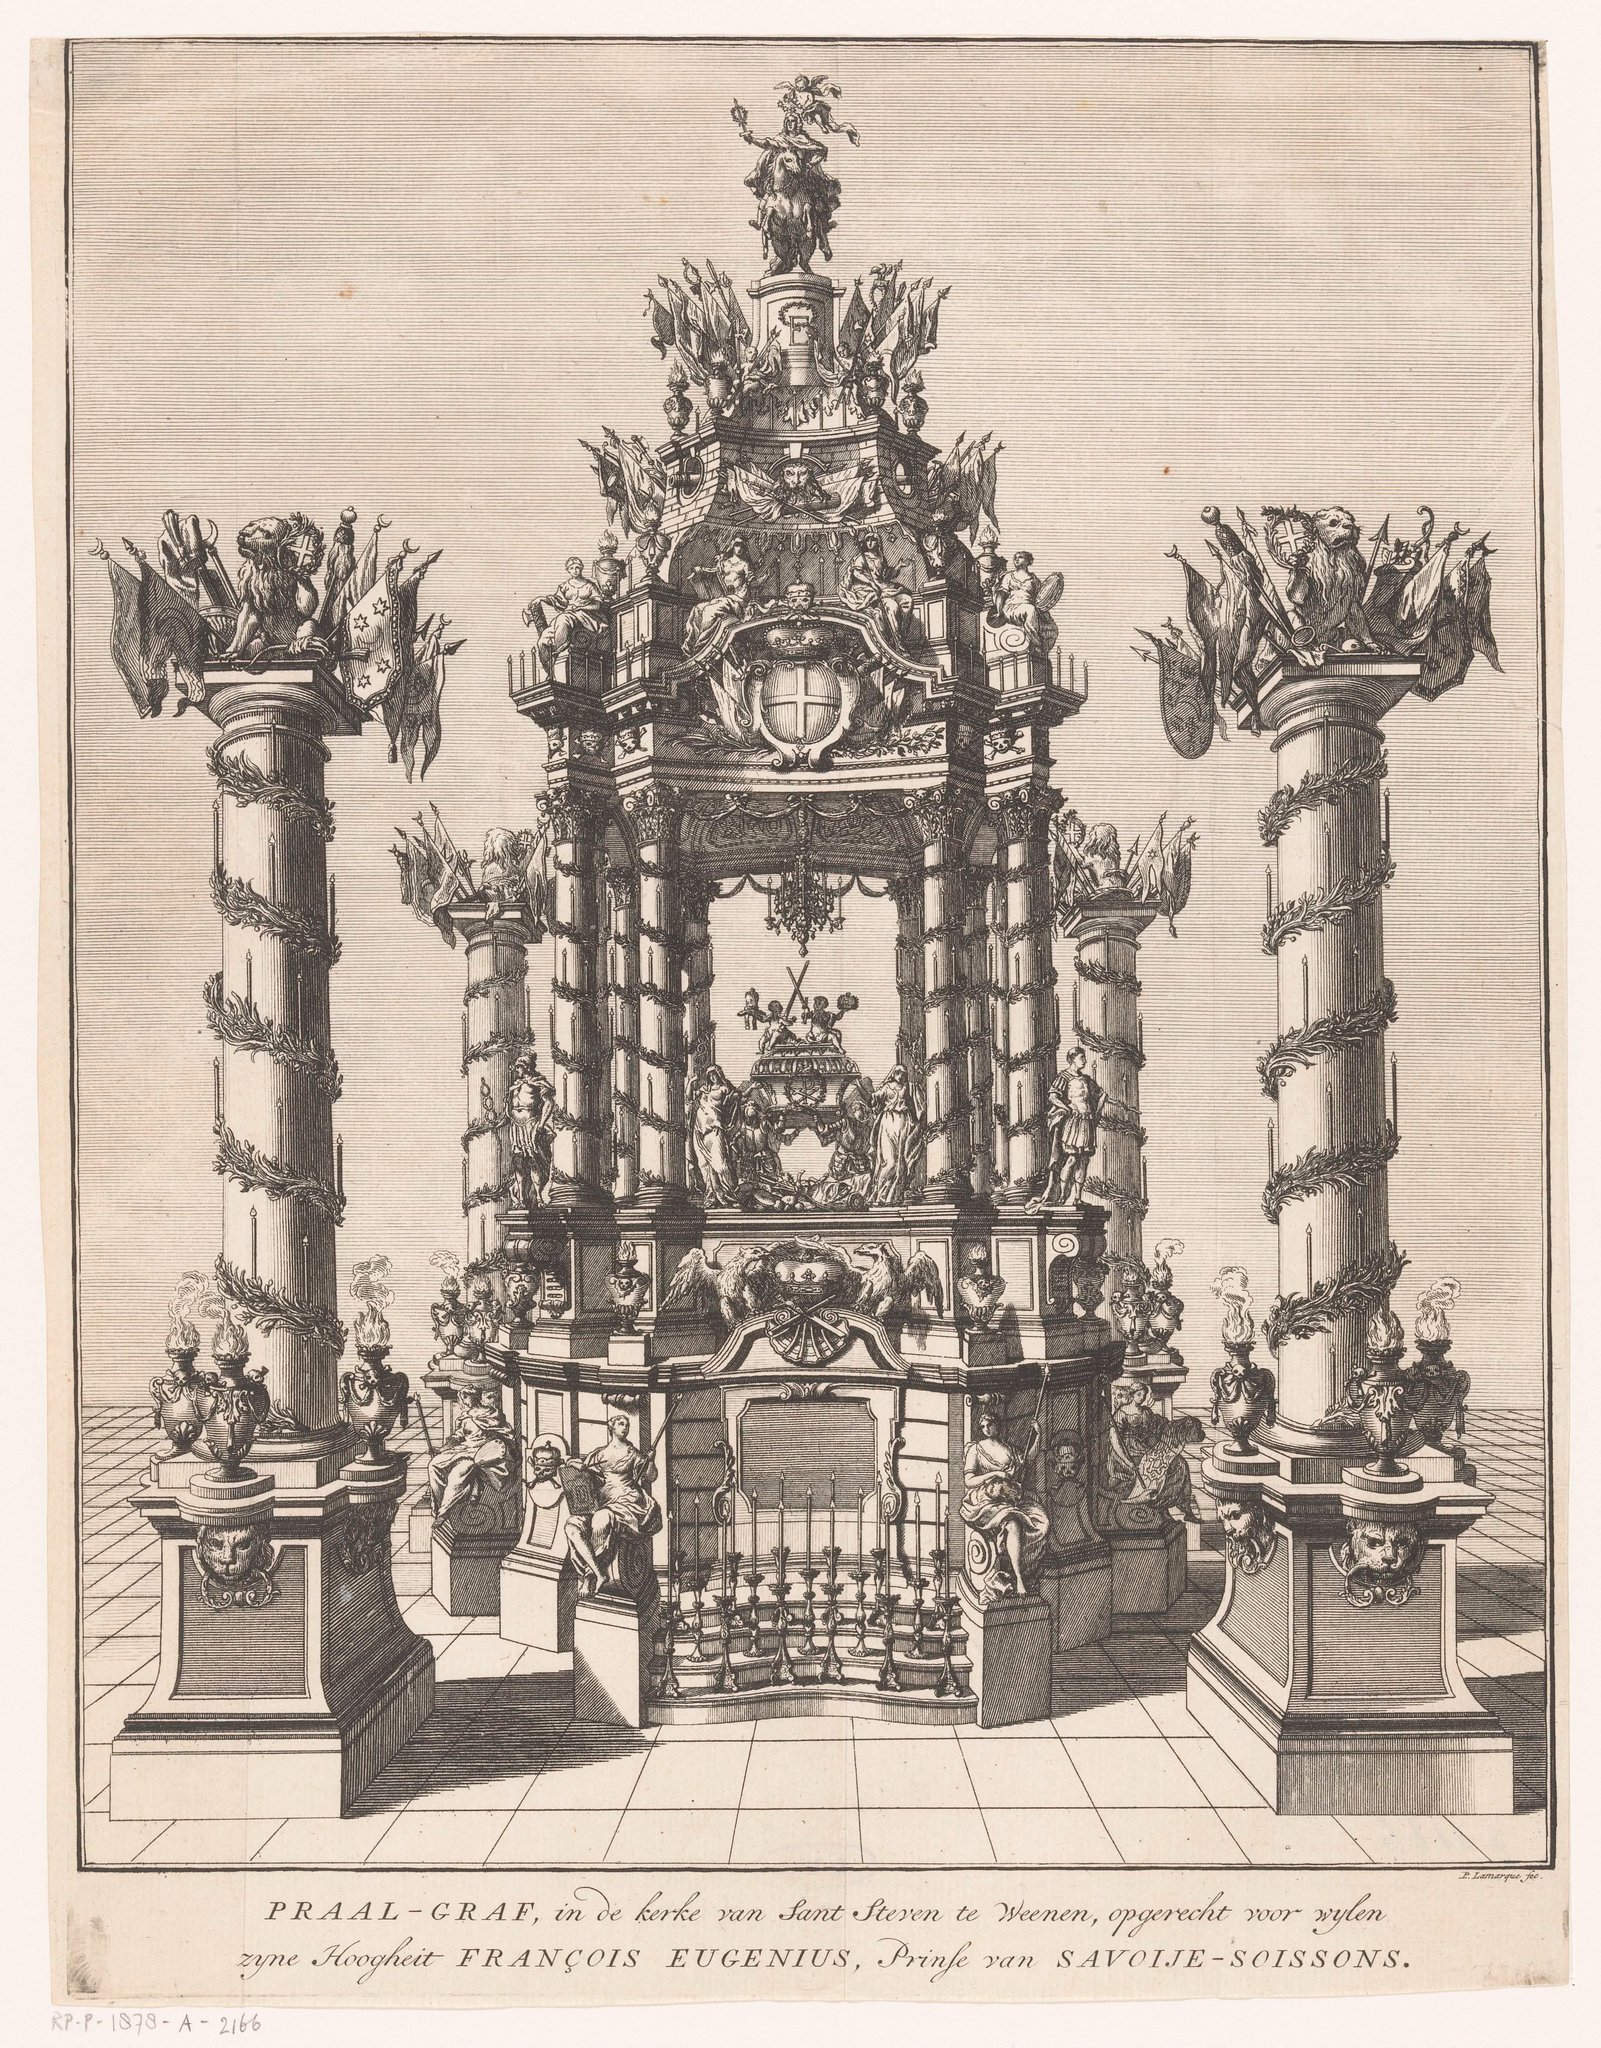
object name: ornament print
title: Praal-Graf, in de kerke van Sant Steven te Weenen, opgerecht voor wylen zyne Hoogheit François Eugenius, Prinse van Savoije-Soissons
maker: pierre lamarque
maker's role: print maker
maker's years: 1716-1766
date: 1726-1766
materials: paper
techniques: engraving, etching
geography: amsterdam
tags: vienna, eugenius van savoye, grave-building, monumental tomb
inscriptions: collector's mark: Lugt 2228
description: Het praalgraf van Eugène-François, prins van Savoye, in de Stephansdom te Wenen. Het graf is gedecoreerd met zuilen en een baldakijn met vlaggen, wapens rookvaten en zittende en staande figuren. Aan weerzijden flankeren zuilen met rookvaten, vlaggen en leeuwen het graf.